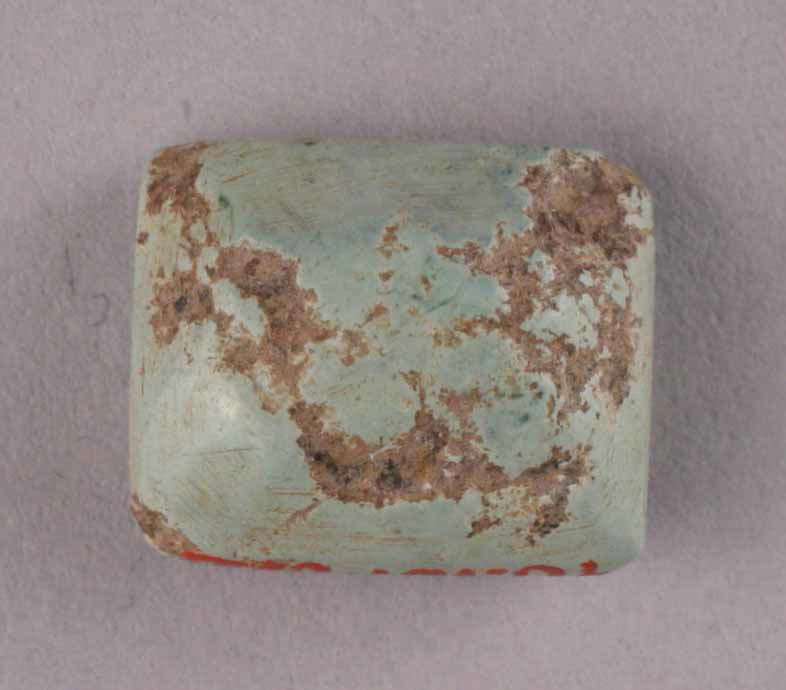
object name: stone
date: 701-1200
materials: stone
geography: iran